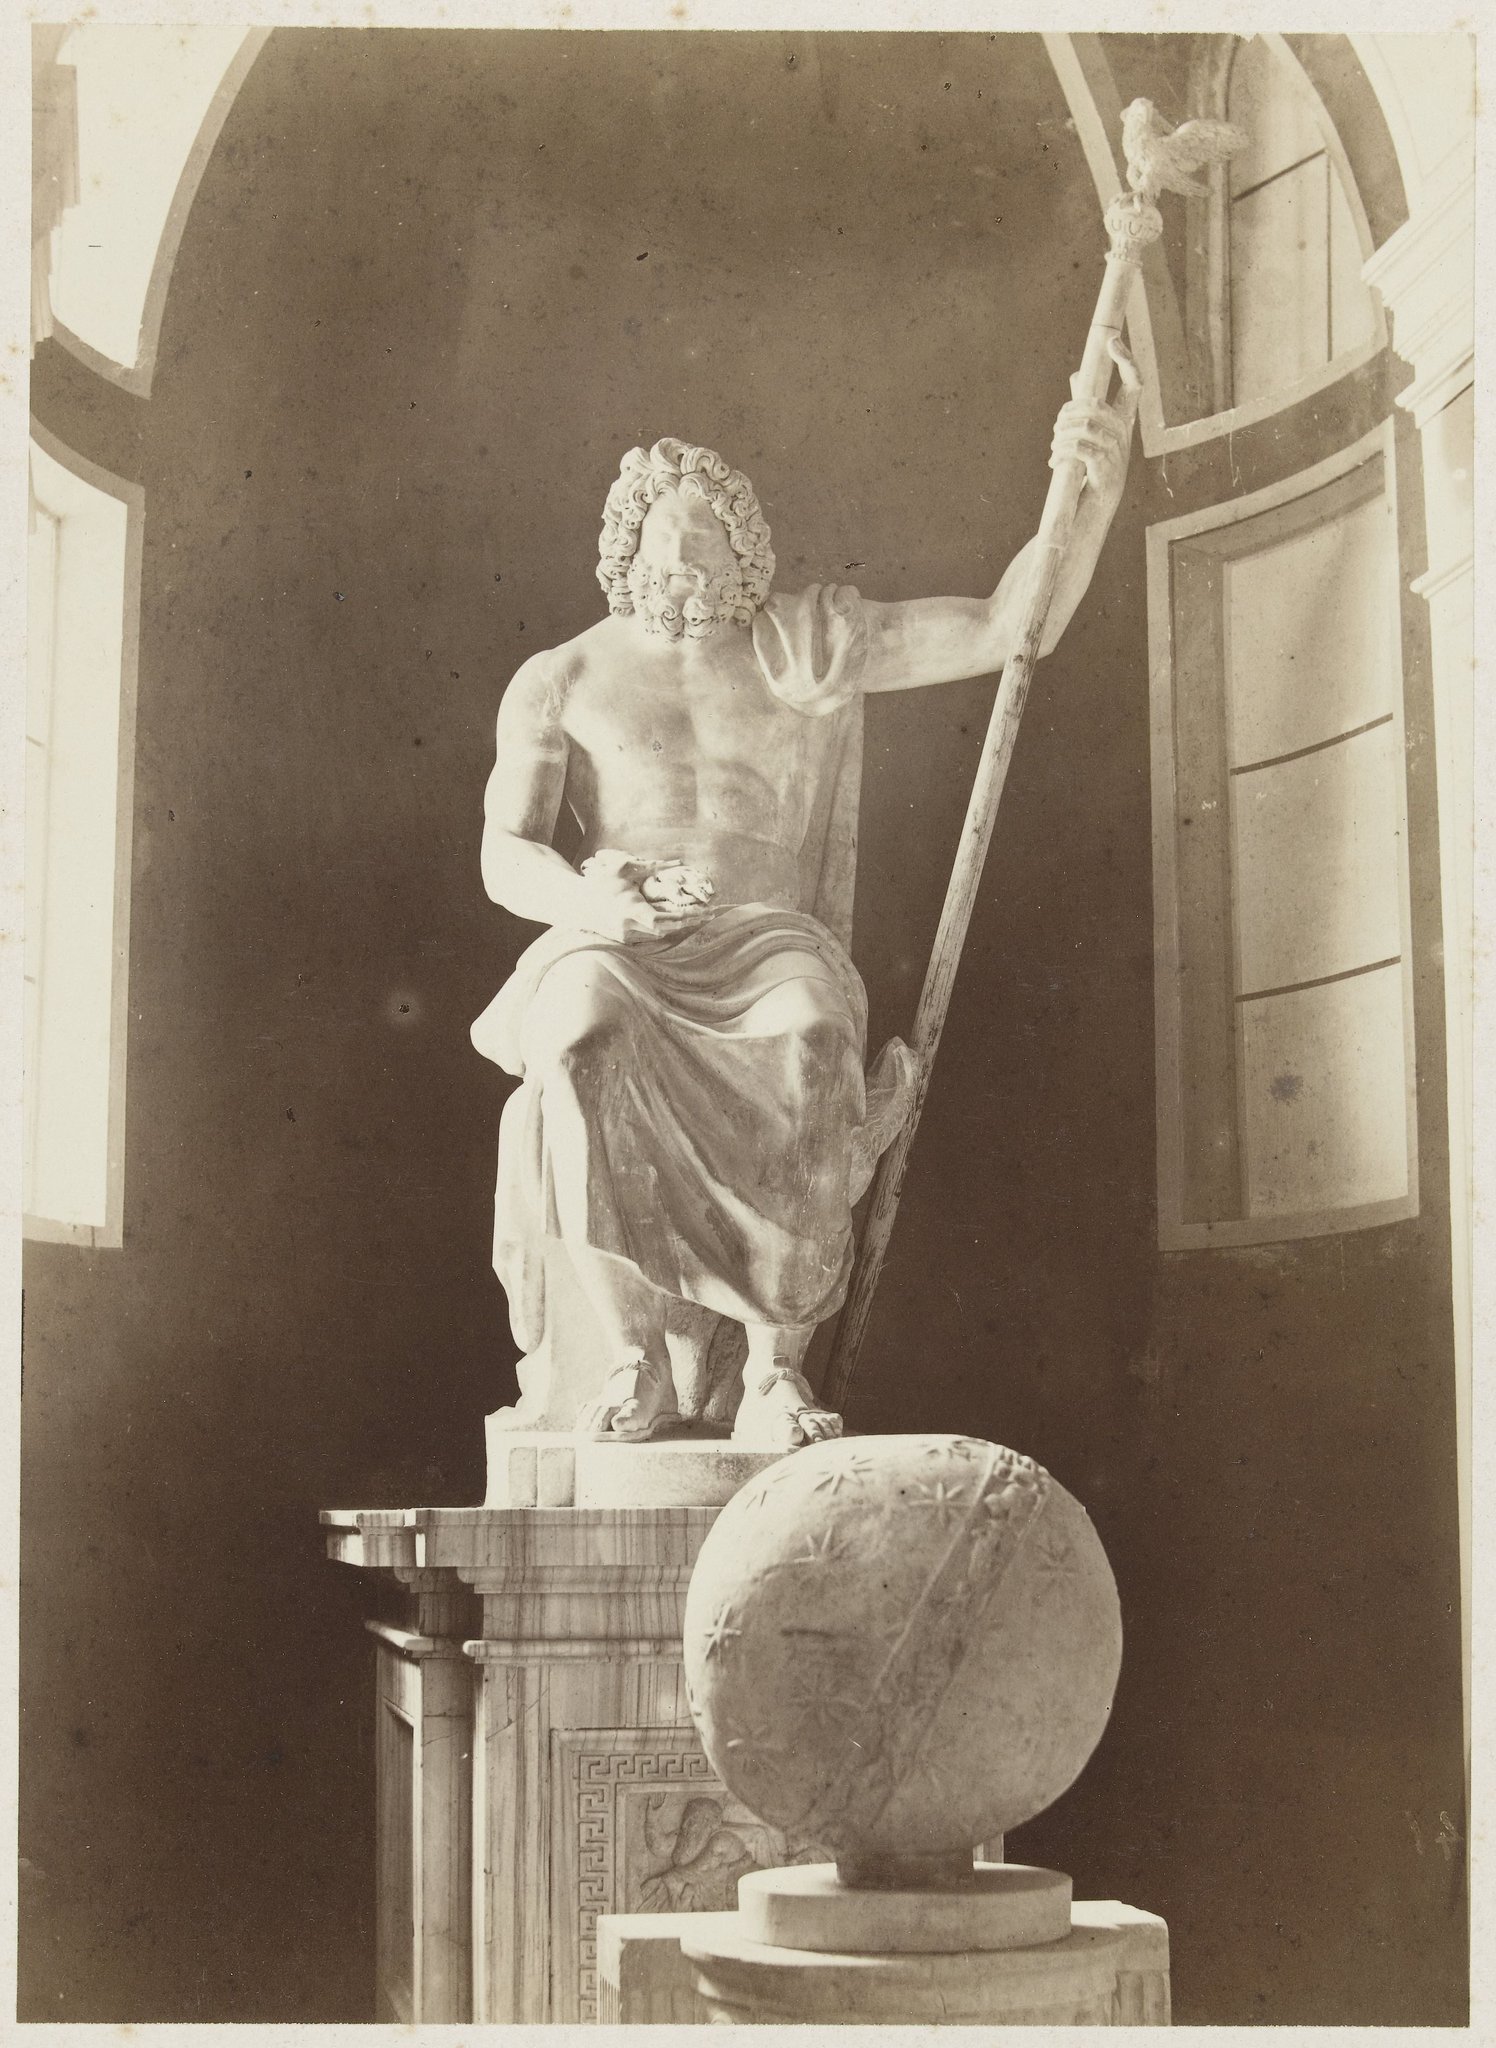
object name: photograph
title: Sculptuur van Jupiter in de Vaticaanse Musea te Vaticaanstad, Italië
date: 1855-1892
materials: cardboard, paper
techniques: albumen print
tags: (story of) jupiter (zeus), piece of sculpture, reproduction of a piece of sculpture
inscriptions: check stamp: ‘Libreria Spithover Roma’, inscription: ‘Jupiter. Vaticaan’, retailer's mark: ‘VOSMAER’